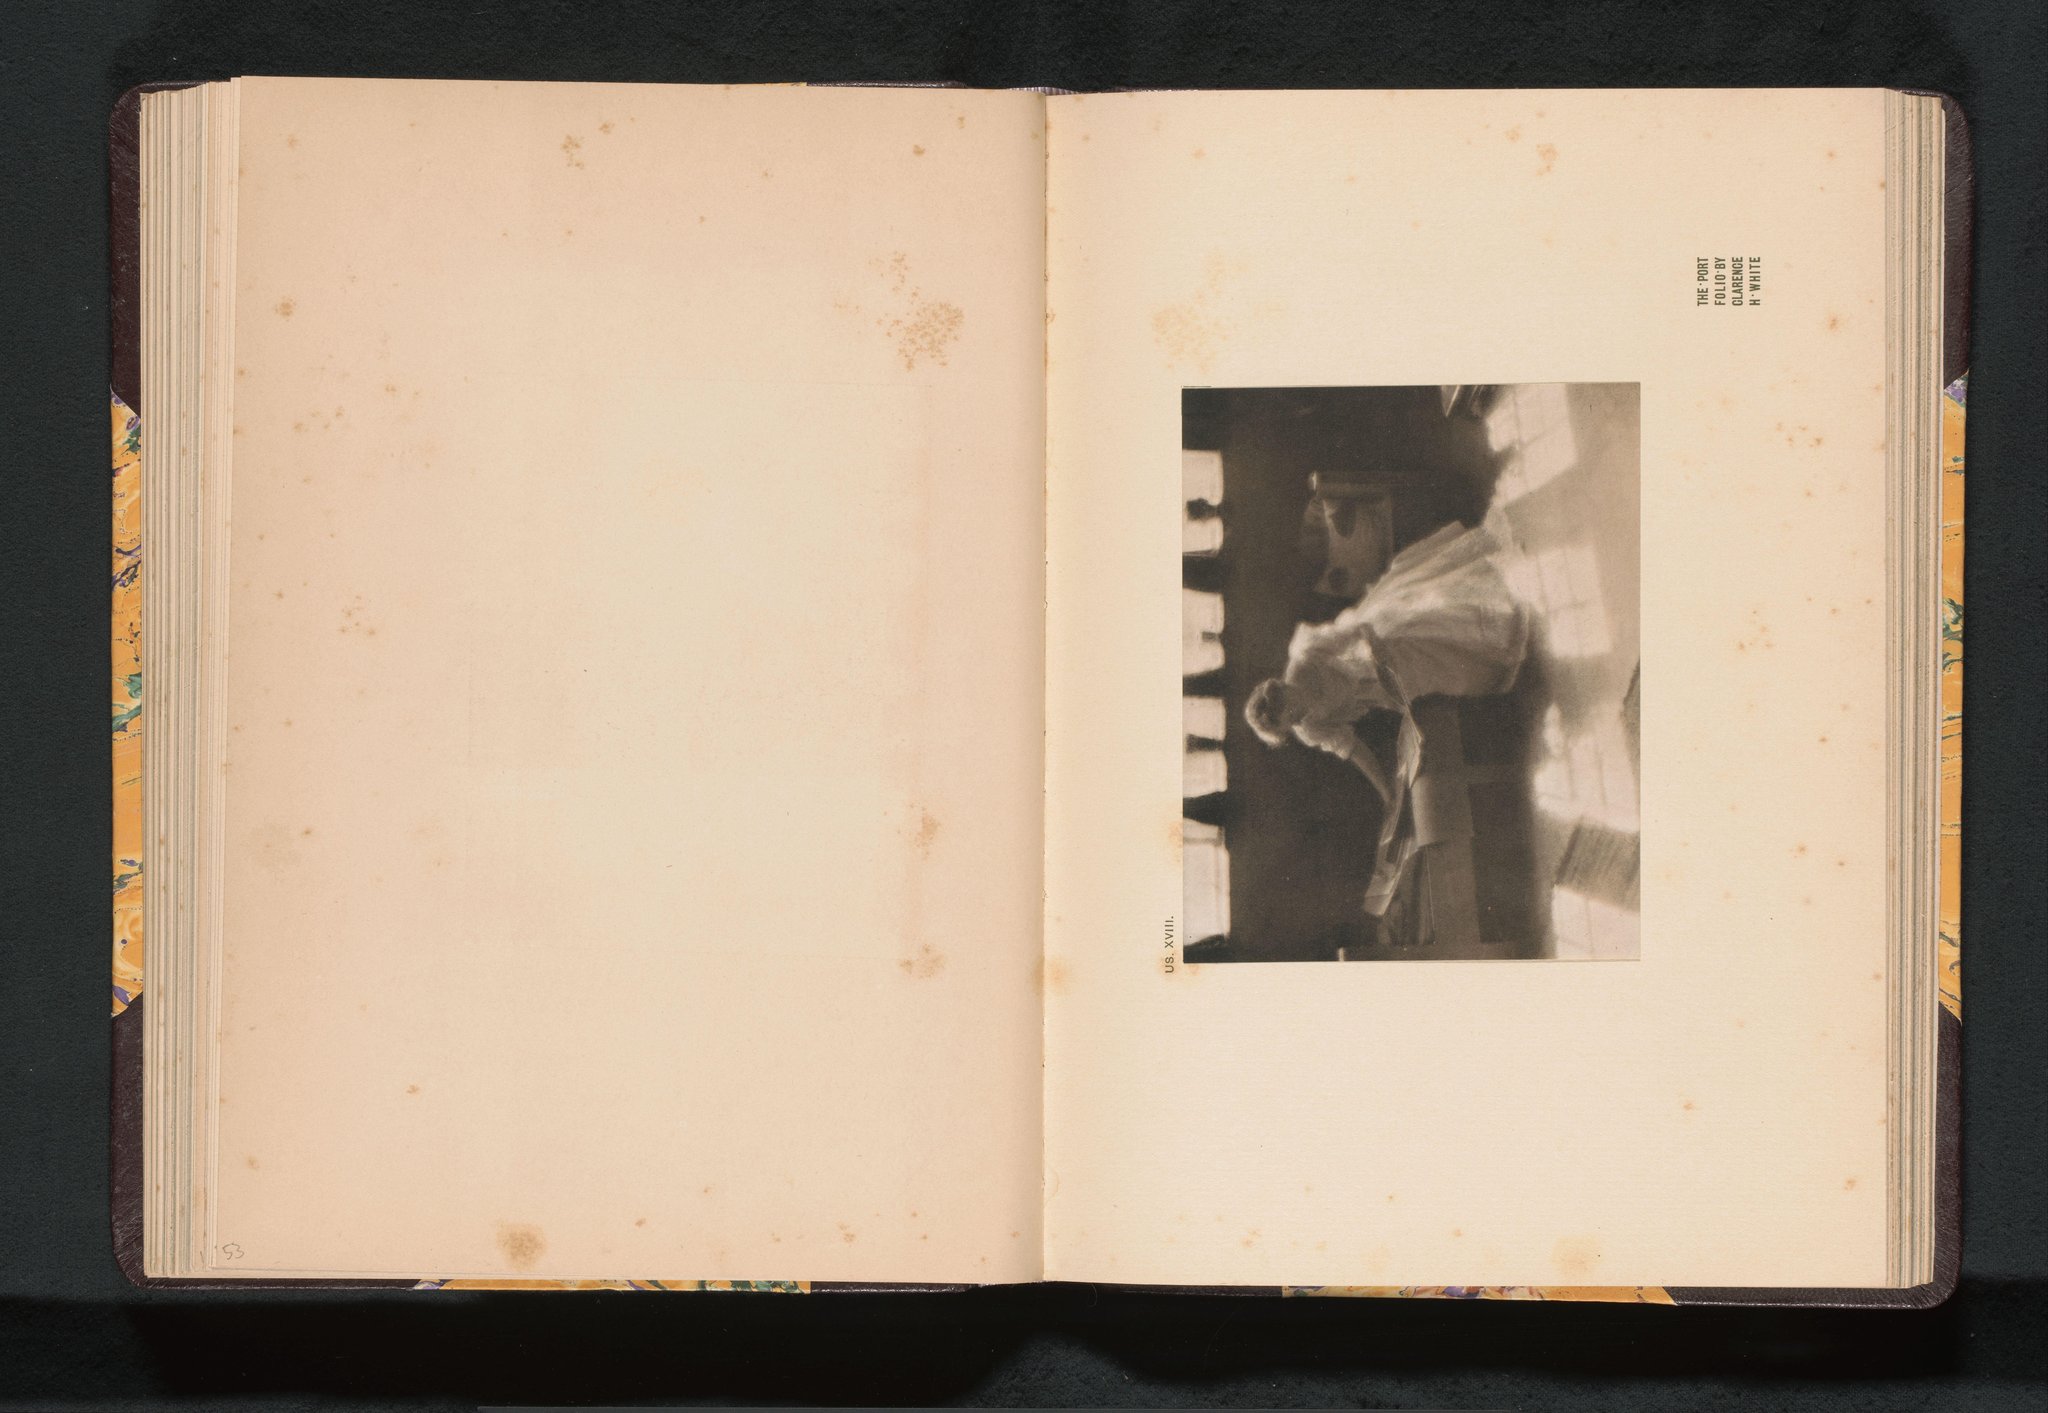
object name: page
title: Zittende onbekende vrouw bekijkt een portfolio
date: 1900-1905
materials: paper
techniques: two-color autotype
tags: sitting on an elevation - aa - female human figure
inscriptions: inscription: ‘US. XVIII.’, inscription: ‘The portfolio by Clarence H. White’